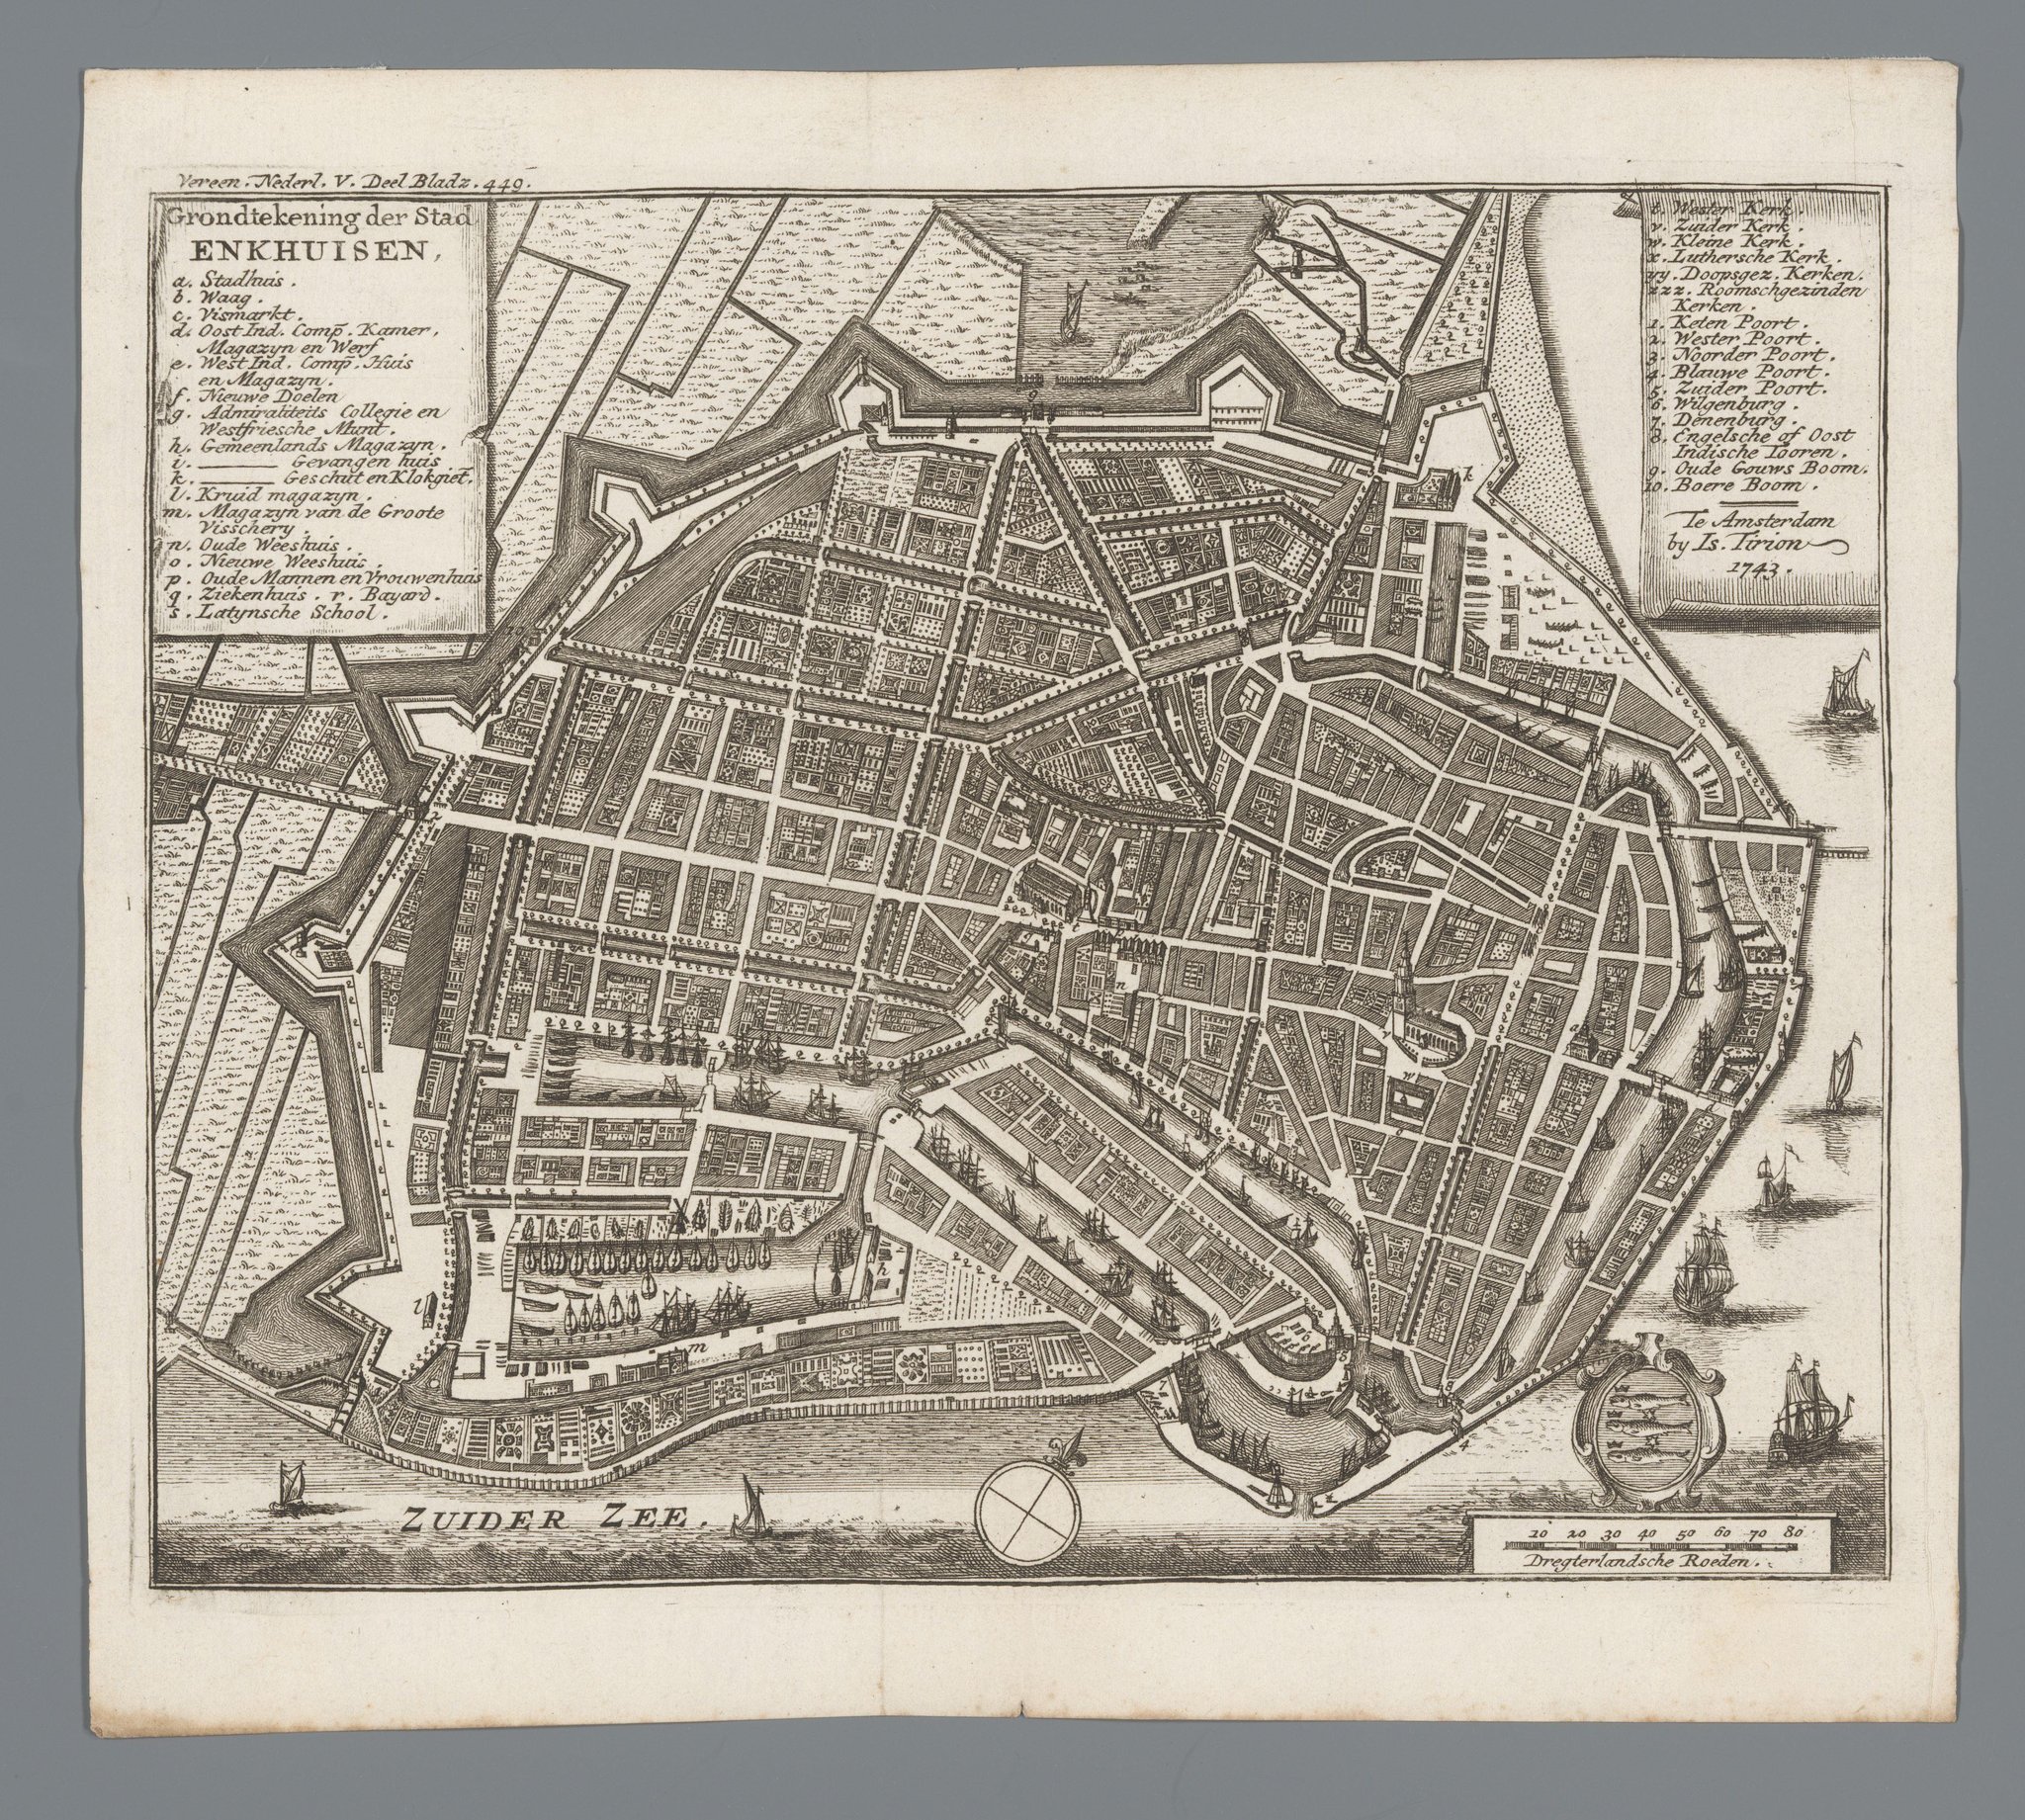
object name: print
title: Grondtekening der Stad Enkhuisen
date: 1743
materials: paper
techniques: etching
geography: amsterdam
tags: maps of cities, enkhuizen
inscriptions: collector's mark: Lugt 2228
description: Prent uit: Tegenwoordige Staat der Vereenigde Nederlanden (...). Amsterdam: Isaak Tirion, 1744, dl. 5, p. 449.